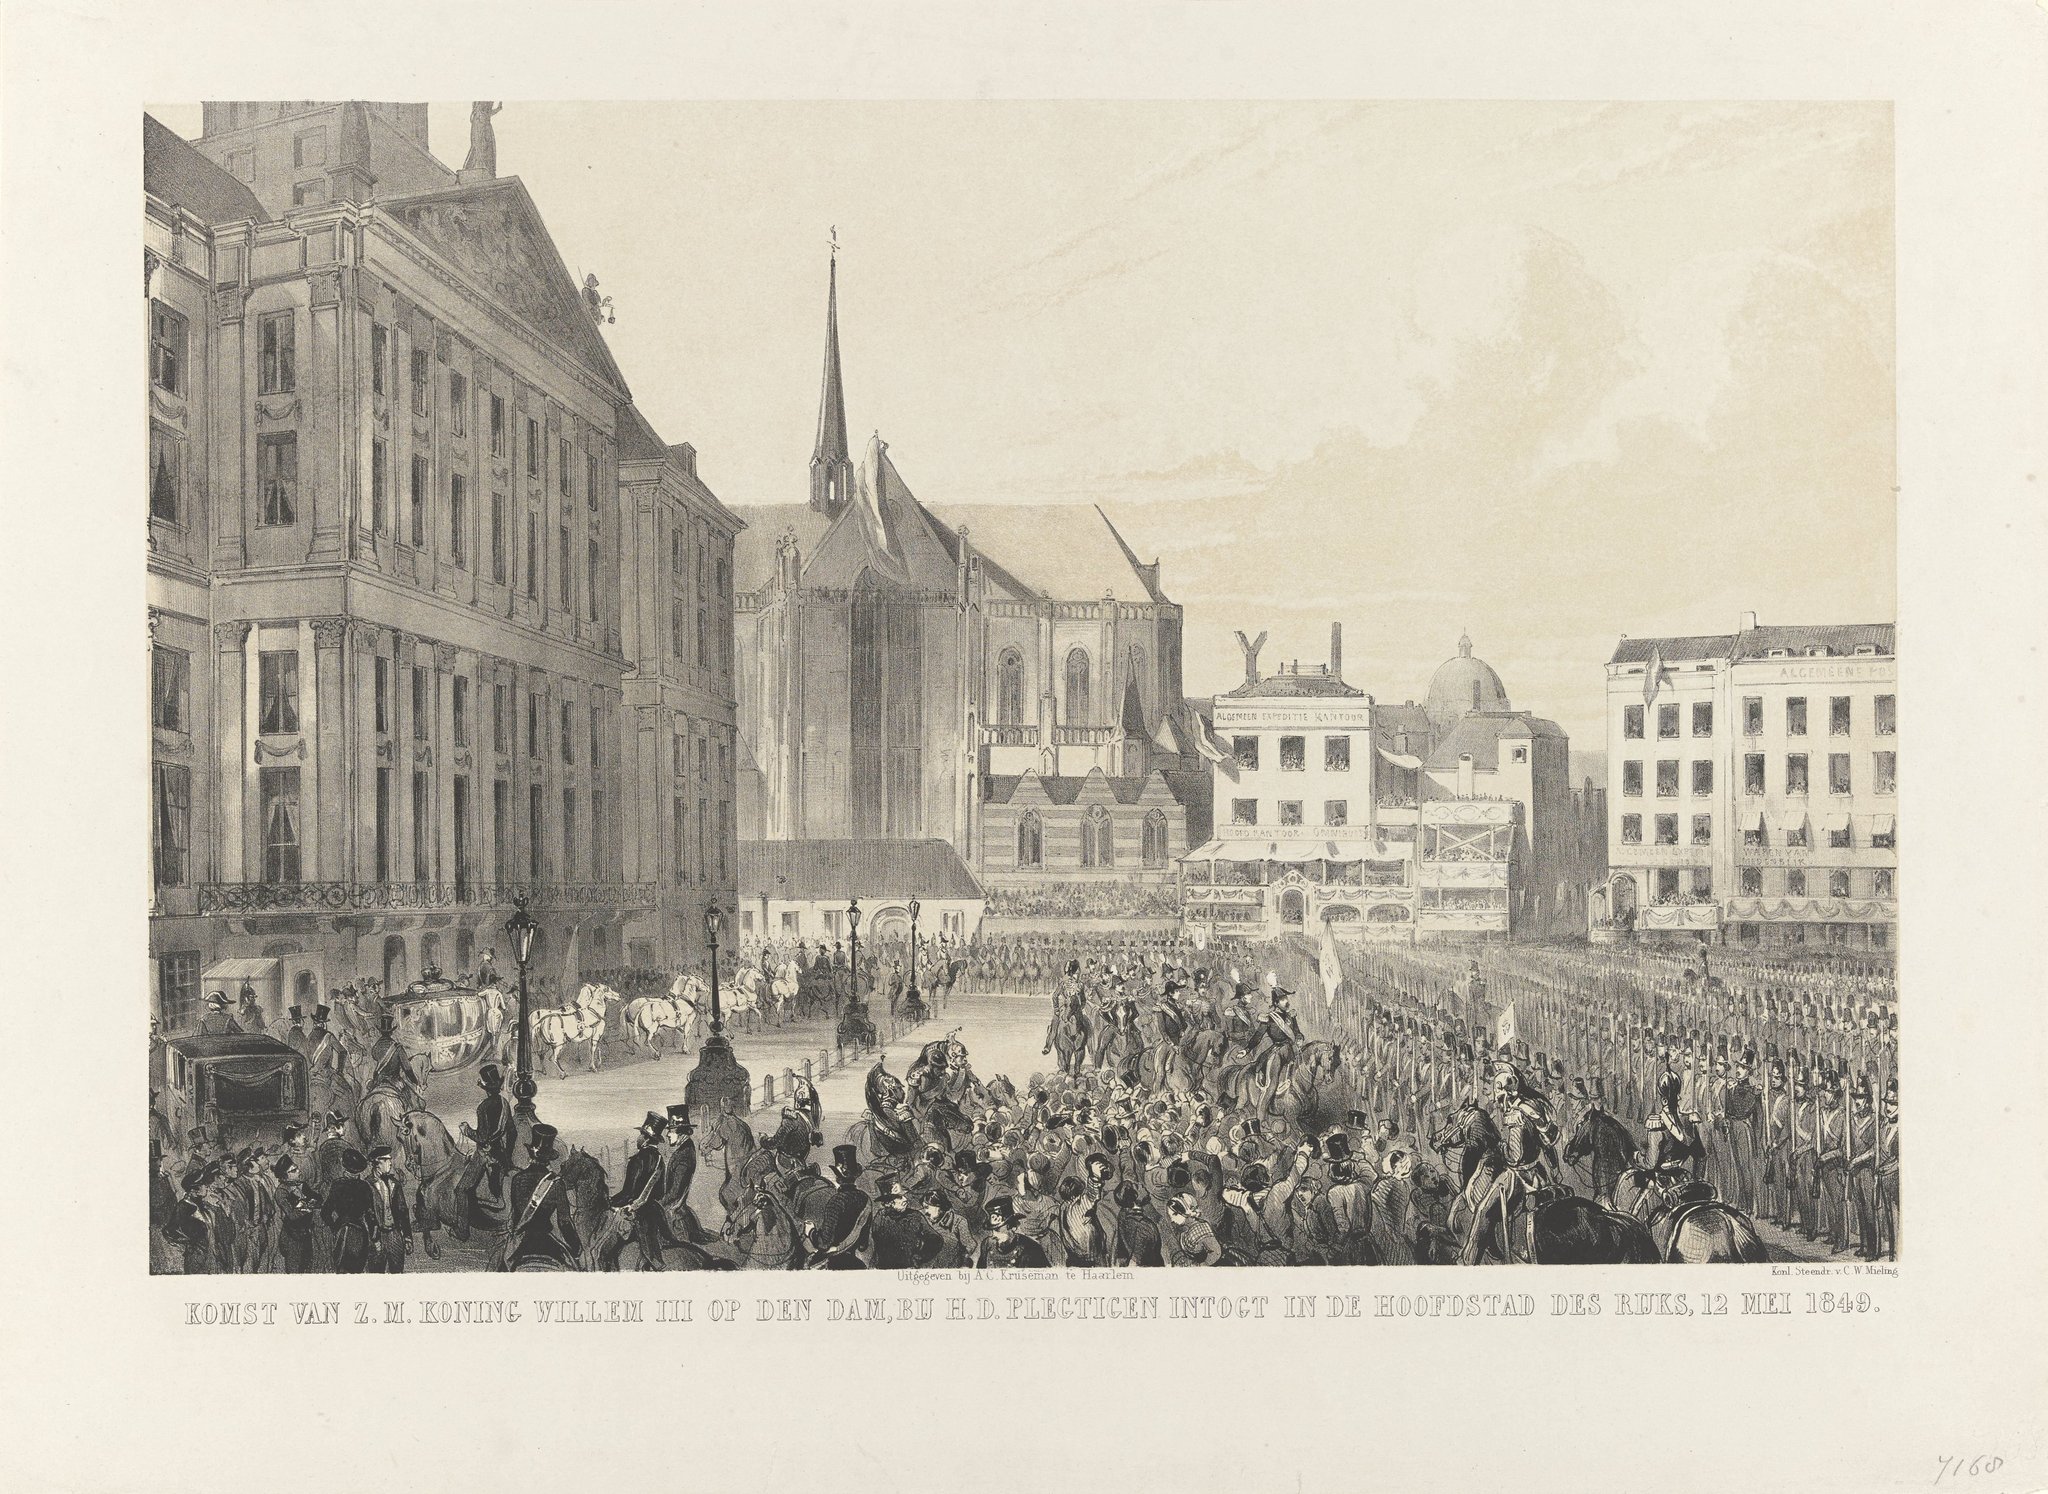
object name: print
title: Komst van Z.M. Koning Willem III op den Dam, bij H.D. plegtigen intogt in de hoofdstad des rijks, 12 mei 1849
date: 1849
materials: paper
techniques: tone lithography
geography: netherlands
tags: willem iii (koning der nederlanden), installation of a ruler, amsterdam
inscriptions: collector's mark: Lugt 2228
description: Uitgegeven als losse plaat bij: Gedenkschrift van de inhuldiging des Konings Willem III, binnen de hoofdstad des Rijks, 12 Mei 1849 / door A.L.G. Toussaint. Haarlem: A.C. Kruseman, 1849.